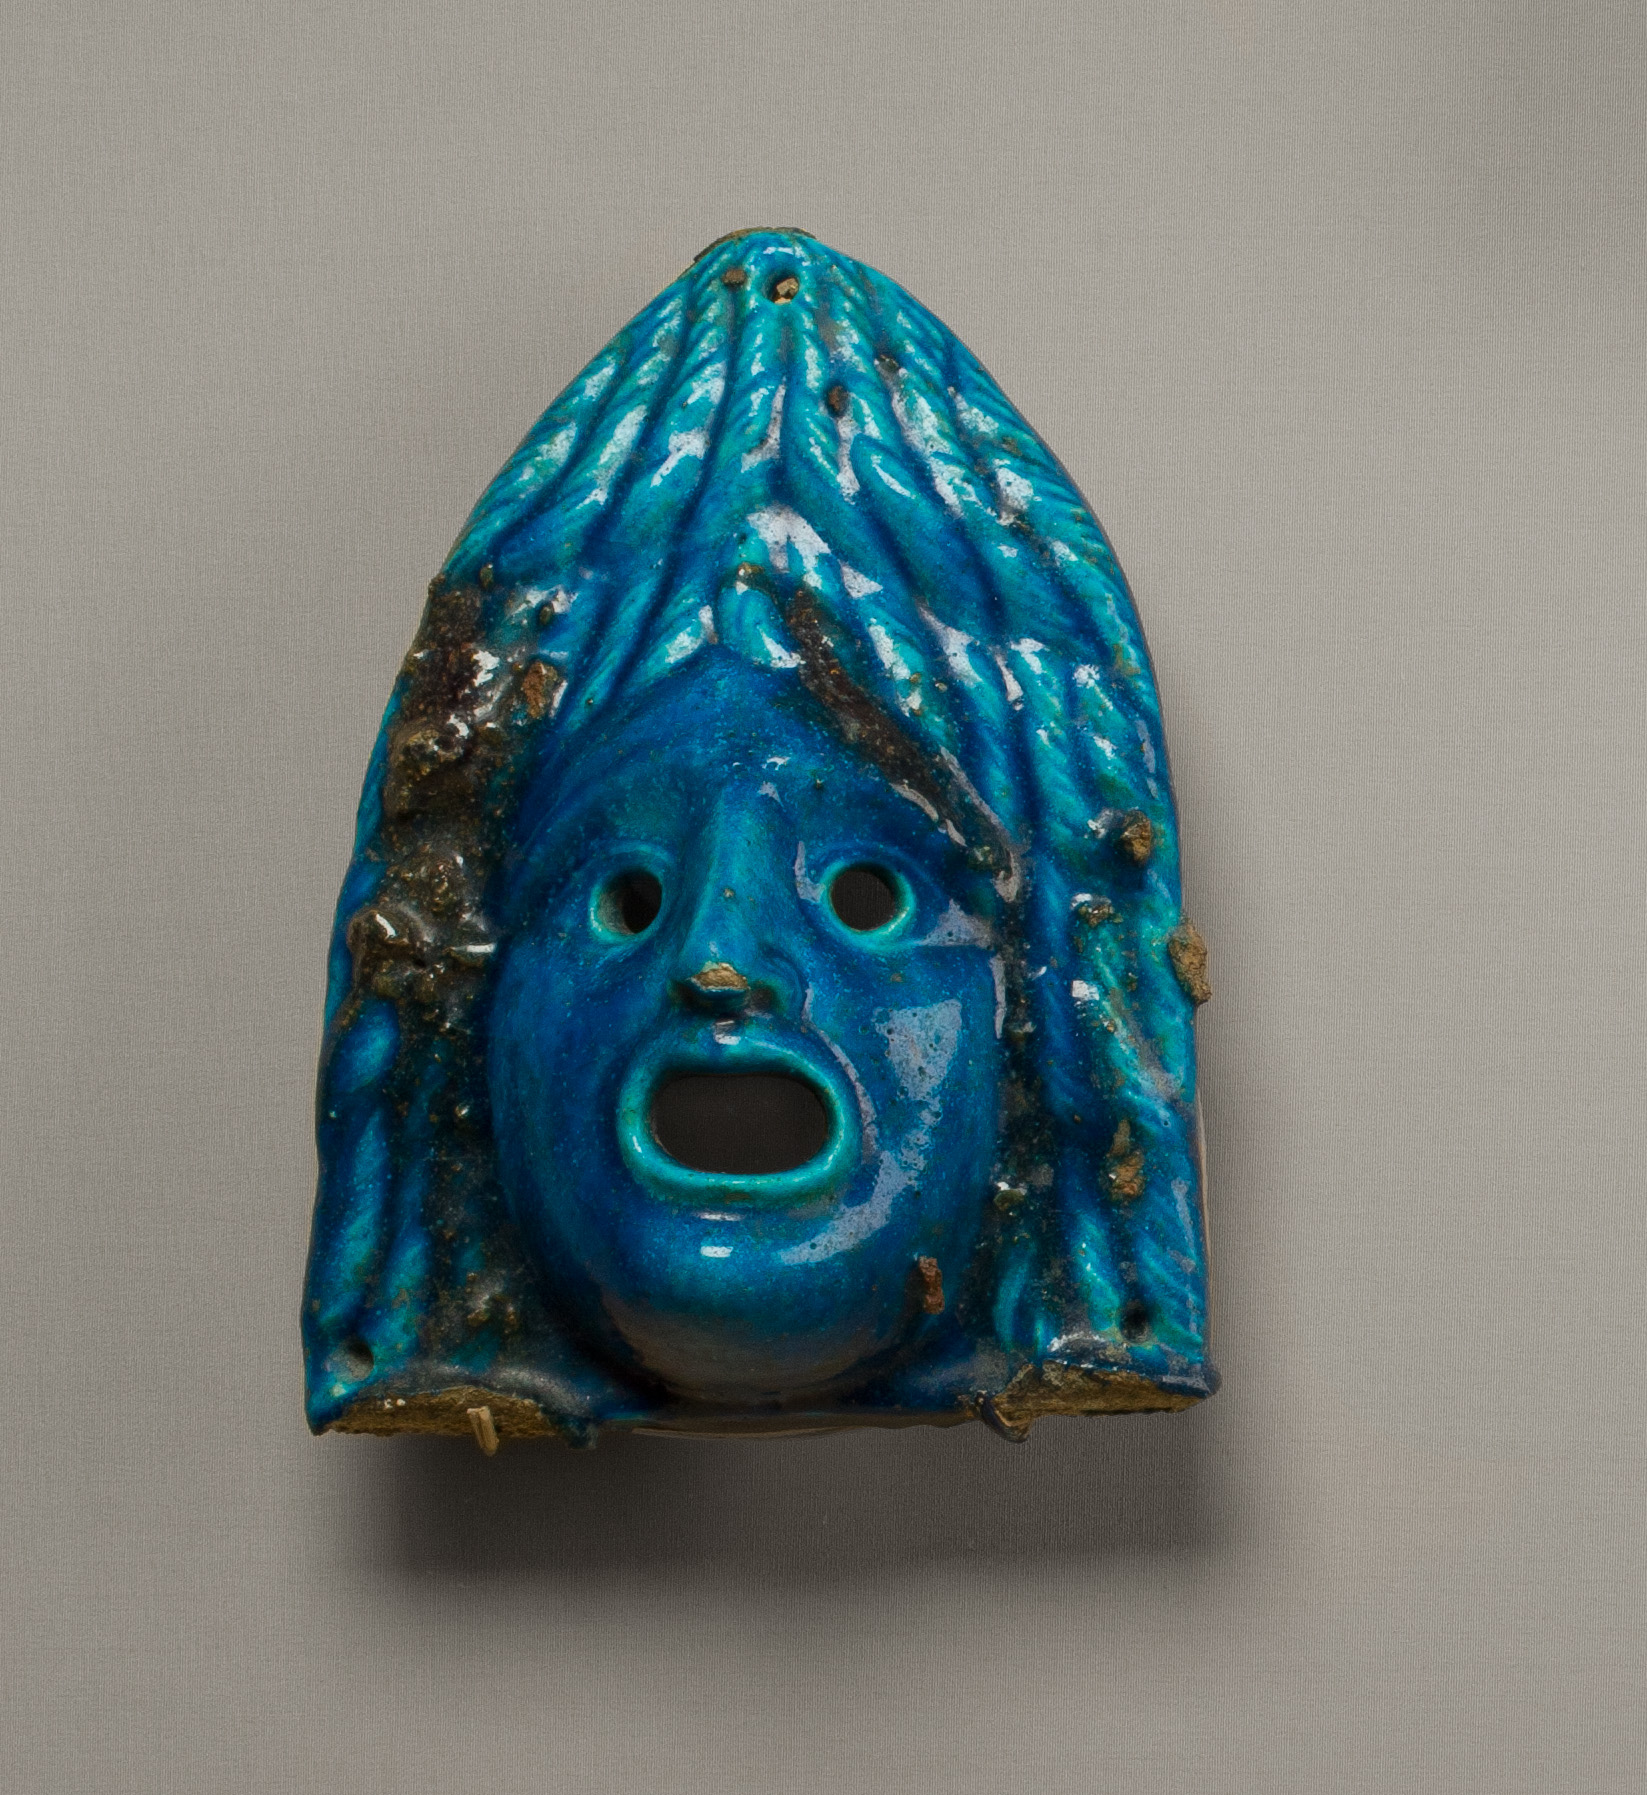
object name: mask, theatrical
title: Theatrical mask for offering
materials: faience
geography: fayum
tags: masks